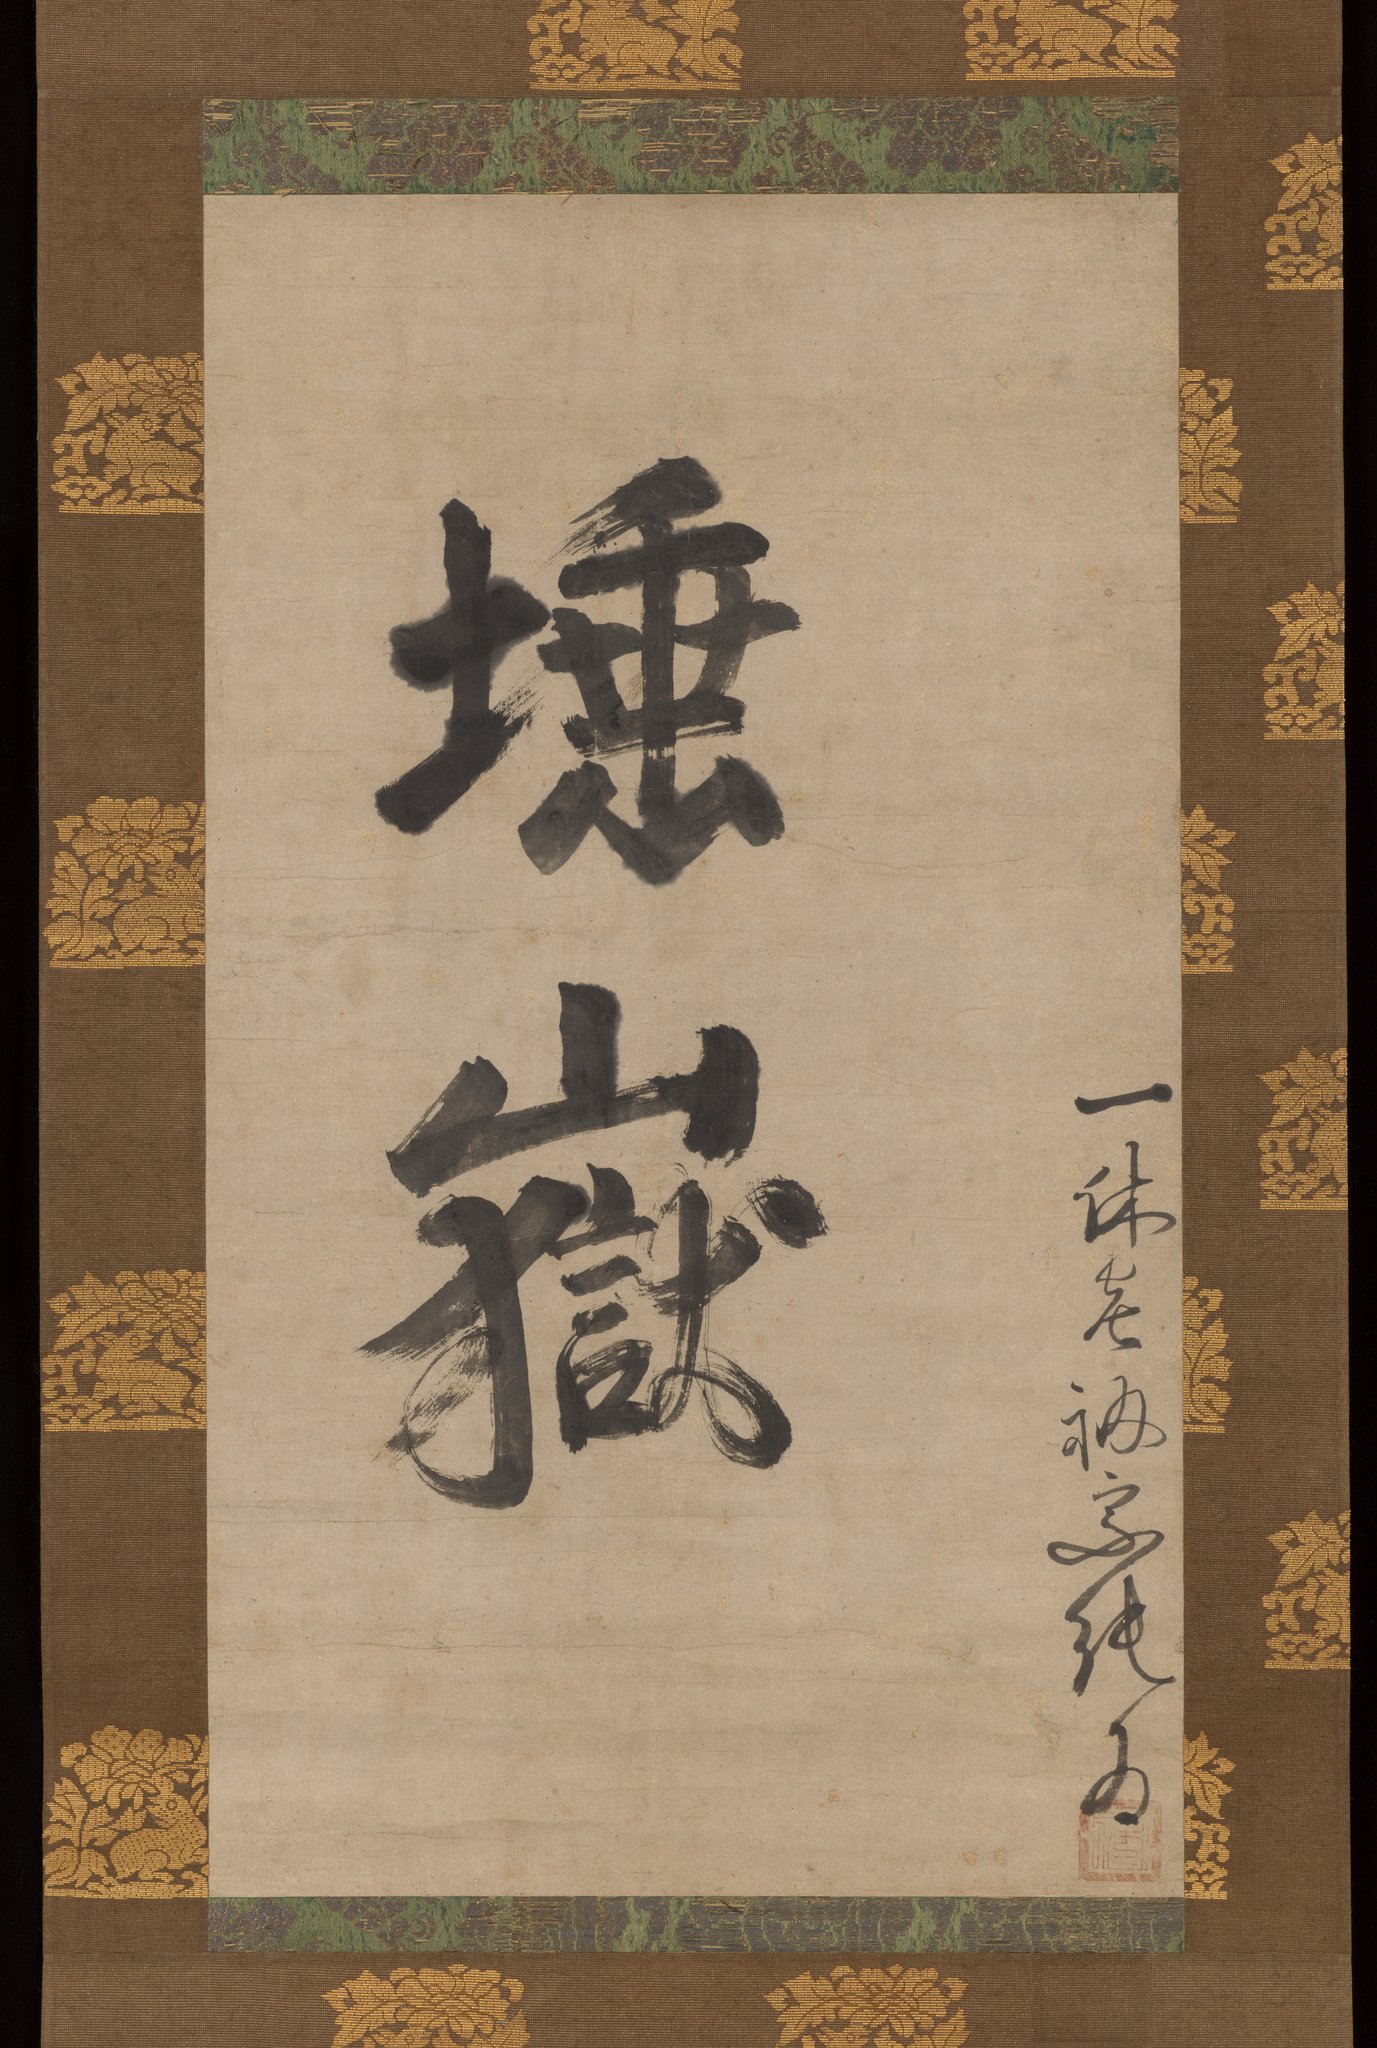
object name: hanging scroll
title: Naming Certificate for "Tagaku"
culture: japanese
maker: ikkyū sōjun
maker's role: artist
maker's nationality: japanese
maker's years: 1394-1481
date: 1401-1500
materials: ink, paper